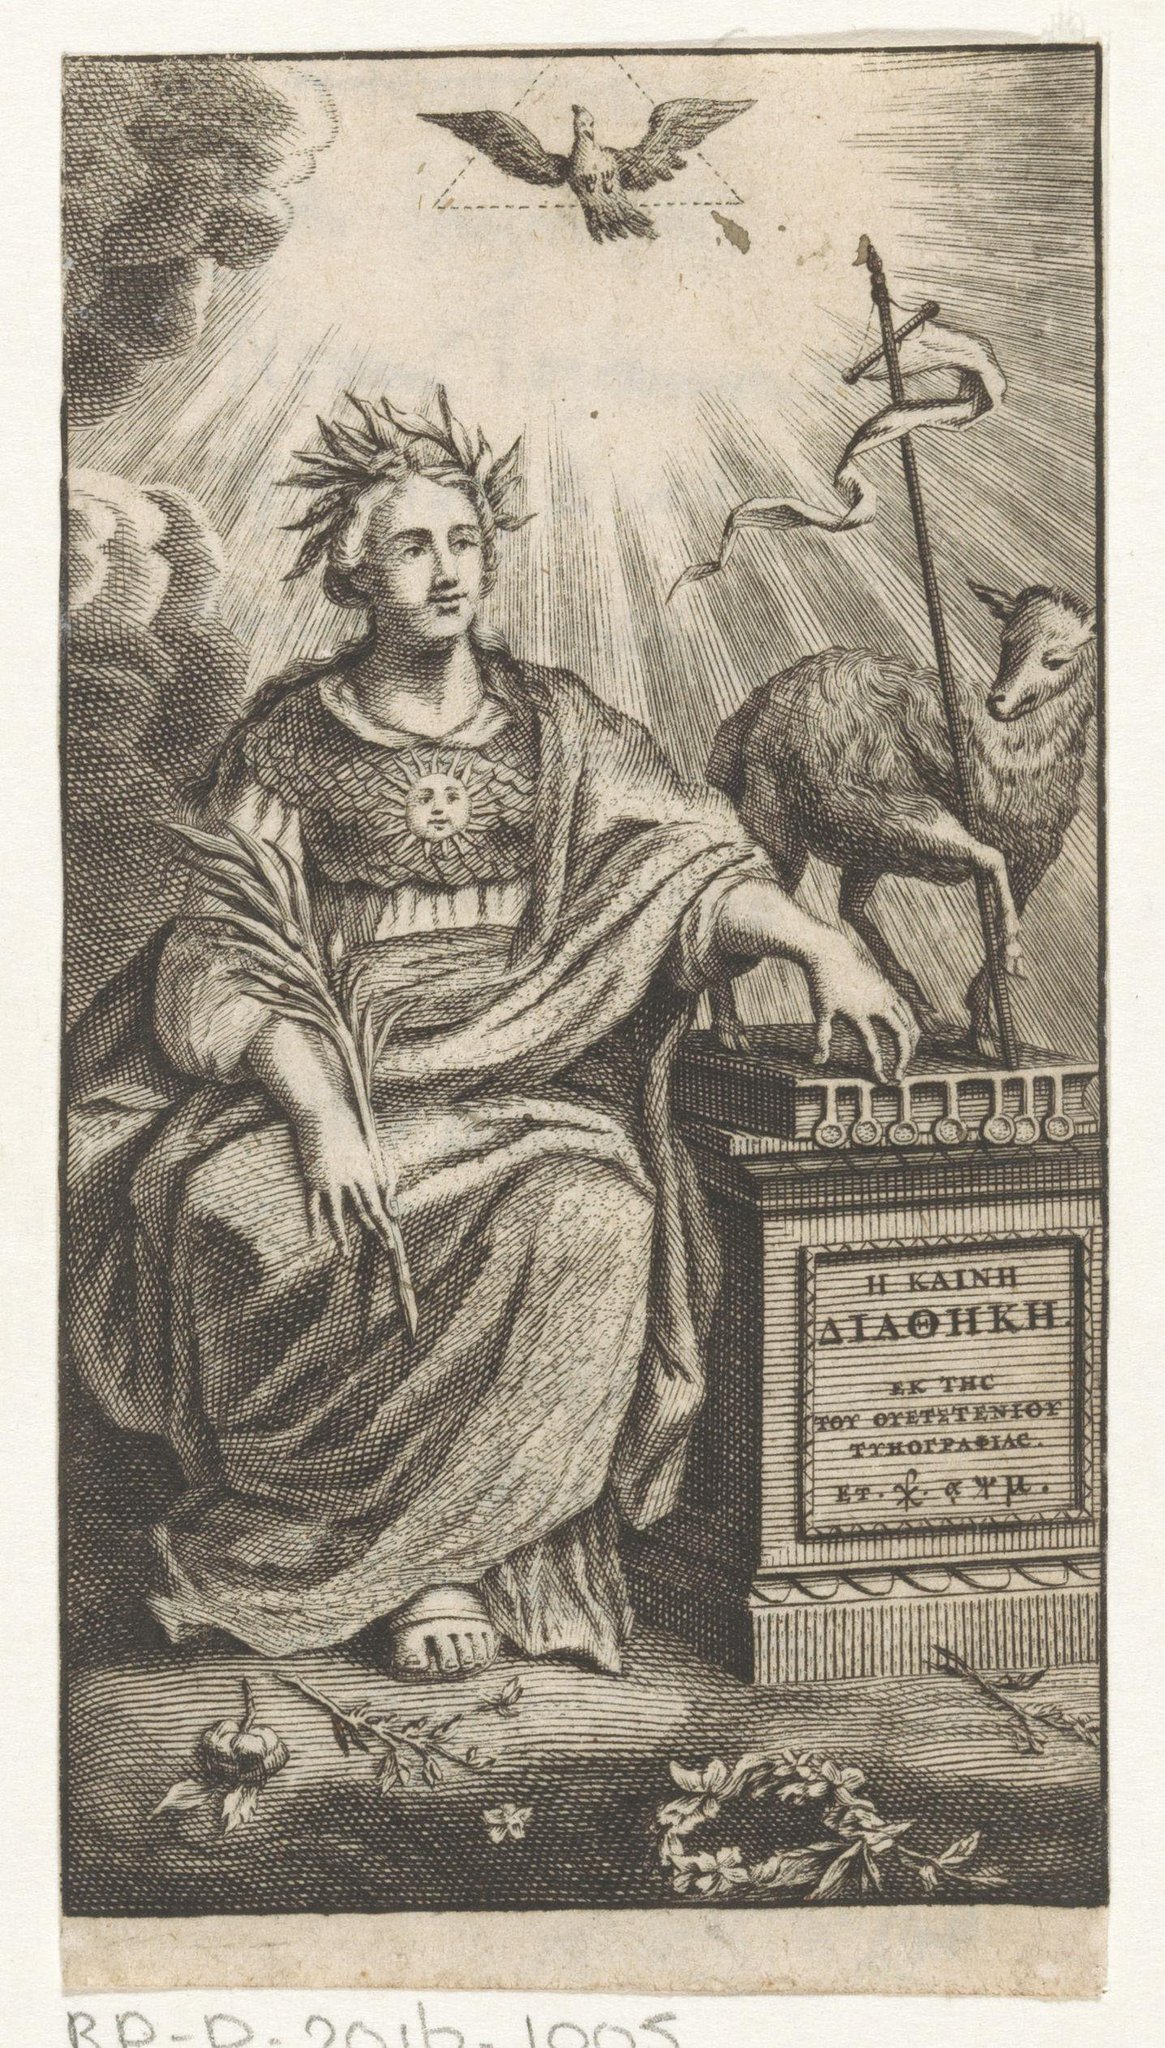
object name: print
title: Titelpagina voor: Johannes Leusden, He Kaine Diatheke. Novum Testamentum, 1740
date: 1740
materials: paper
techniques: engraving, etching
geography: amsterdam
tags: lamb bearing cross or banner, 'agnus dei' ~ symbol of christ, faith, 'fides'; 'fede', 'fede catholica', 'fede christiana', 'fede christiana catholica' (ripa) ~ one of the three theological virtues, the vision of the lamb and the book with the seven seals, holy ghost represented as a dove (in flames)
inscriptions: collector's mark: Lugt 2228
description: De personificatie van het geloof met lauwerkrans, palmtak en zon op de borst zit naast een altaar met Griekse boektitel. Op het altaar het lam met vaandel op het boek met de zeven zegels. In de lucht een duif in driehoek en stralenkrans als symbool van de heilige geest.